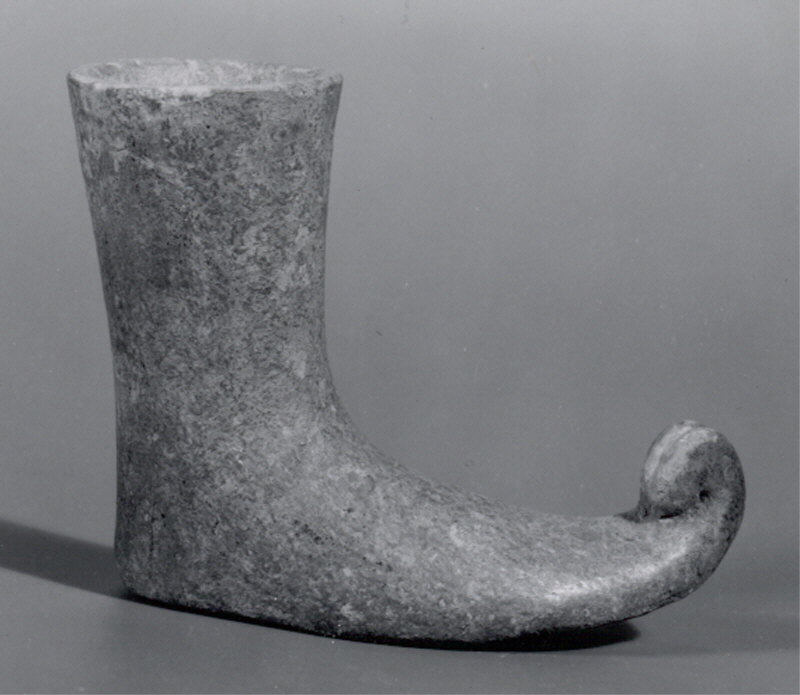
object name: boot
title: Votive boot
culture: iranian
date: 900 BCE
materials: ceramic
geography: northwestern iran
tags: boots